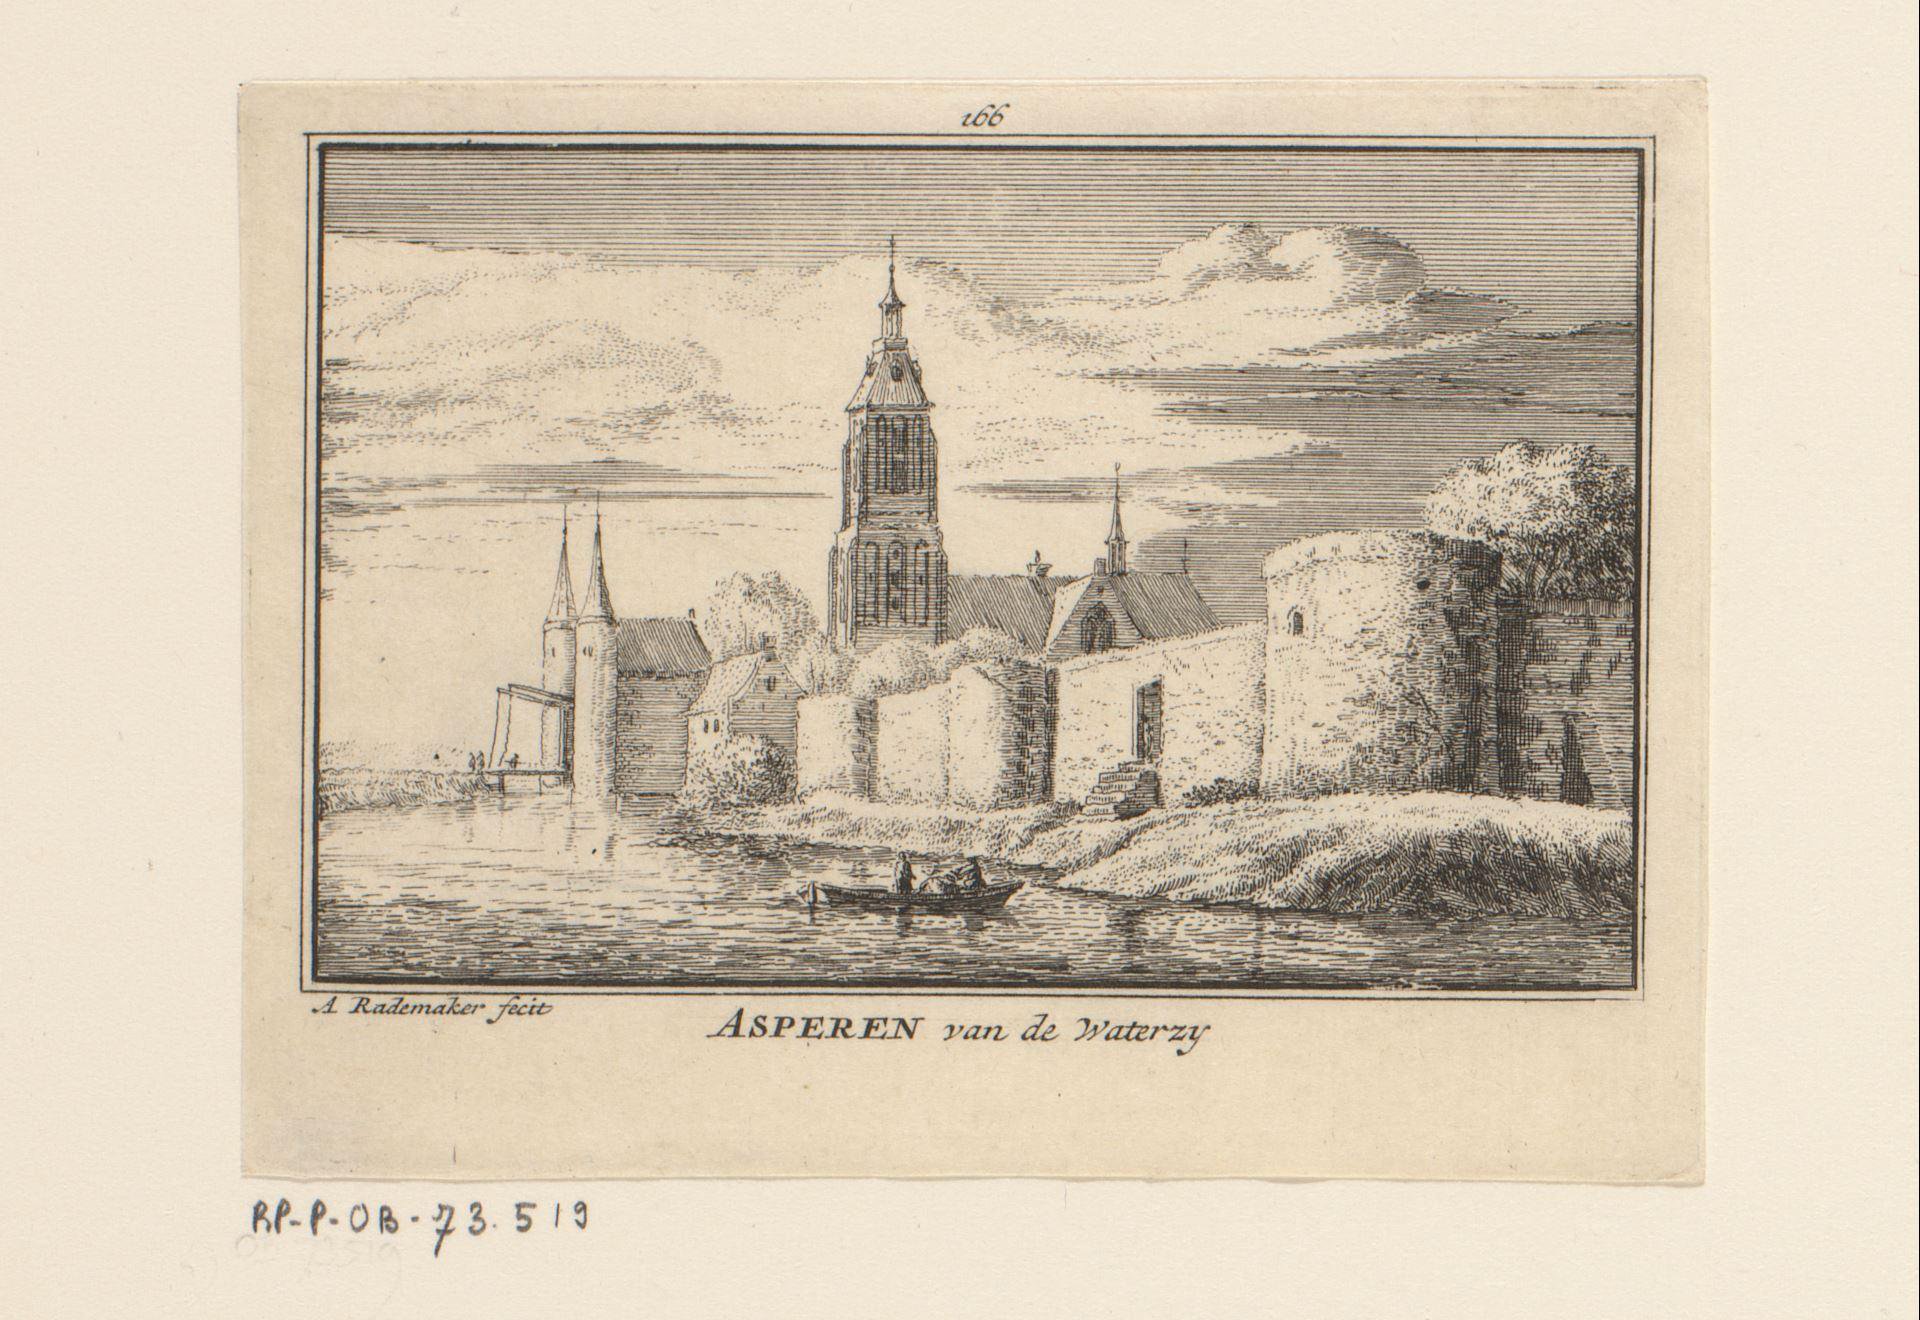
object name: book illustration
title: Asperen van de waterzy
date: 1727-1733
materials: paper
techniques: etching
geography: amsterdam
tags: church (exterior), rowing-boat, canoe, etc., city-walls, city-gate, asperen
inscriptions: collector's mark: Lugt 2228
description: Illustratie uit: Abraham Rademaker, Matthaeus Brouërius van Niedek, Isaac Le Long, Kabinet van Nederlandsche en Kleefsche outheden en (...) voorname stads- en landgebouwen, Willem Barents en Antoni Schoonenburg: Amsterdam, 1727-1733, ill. nr. 166.